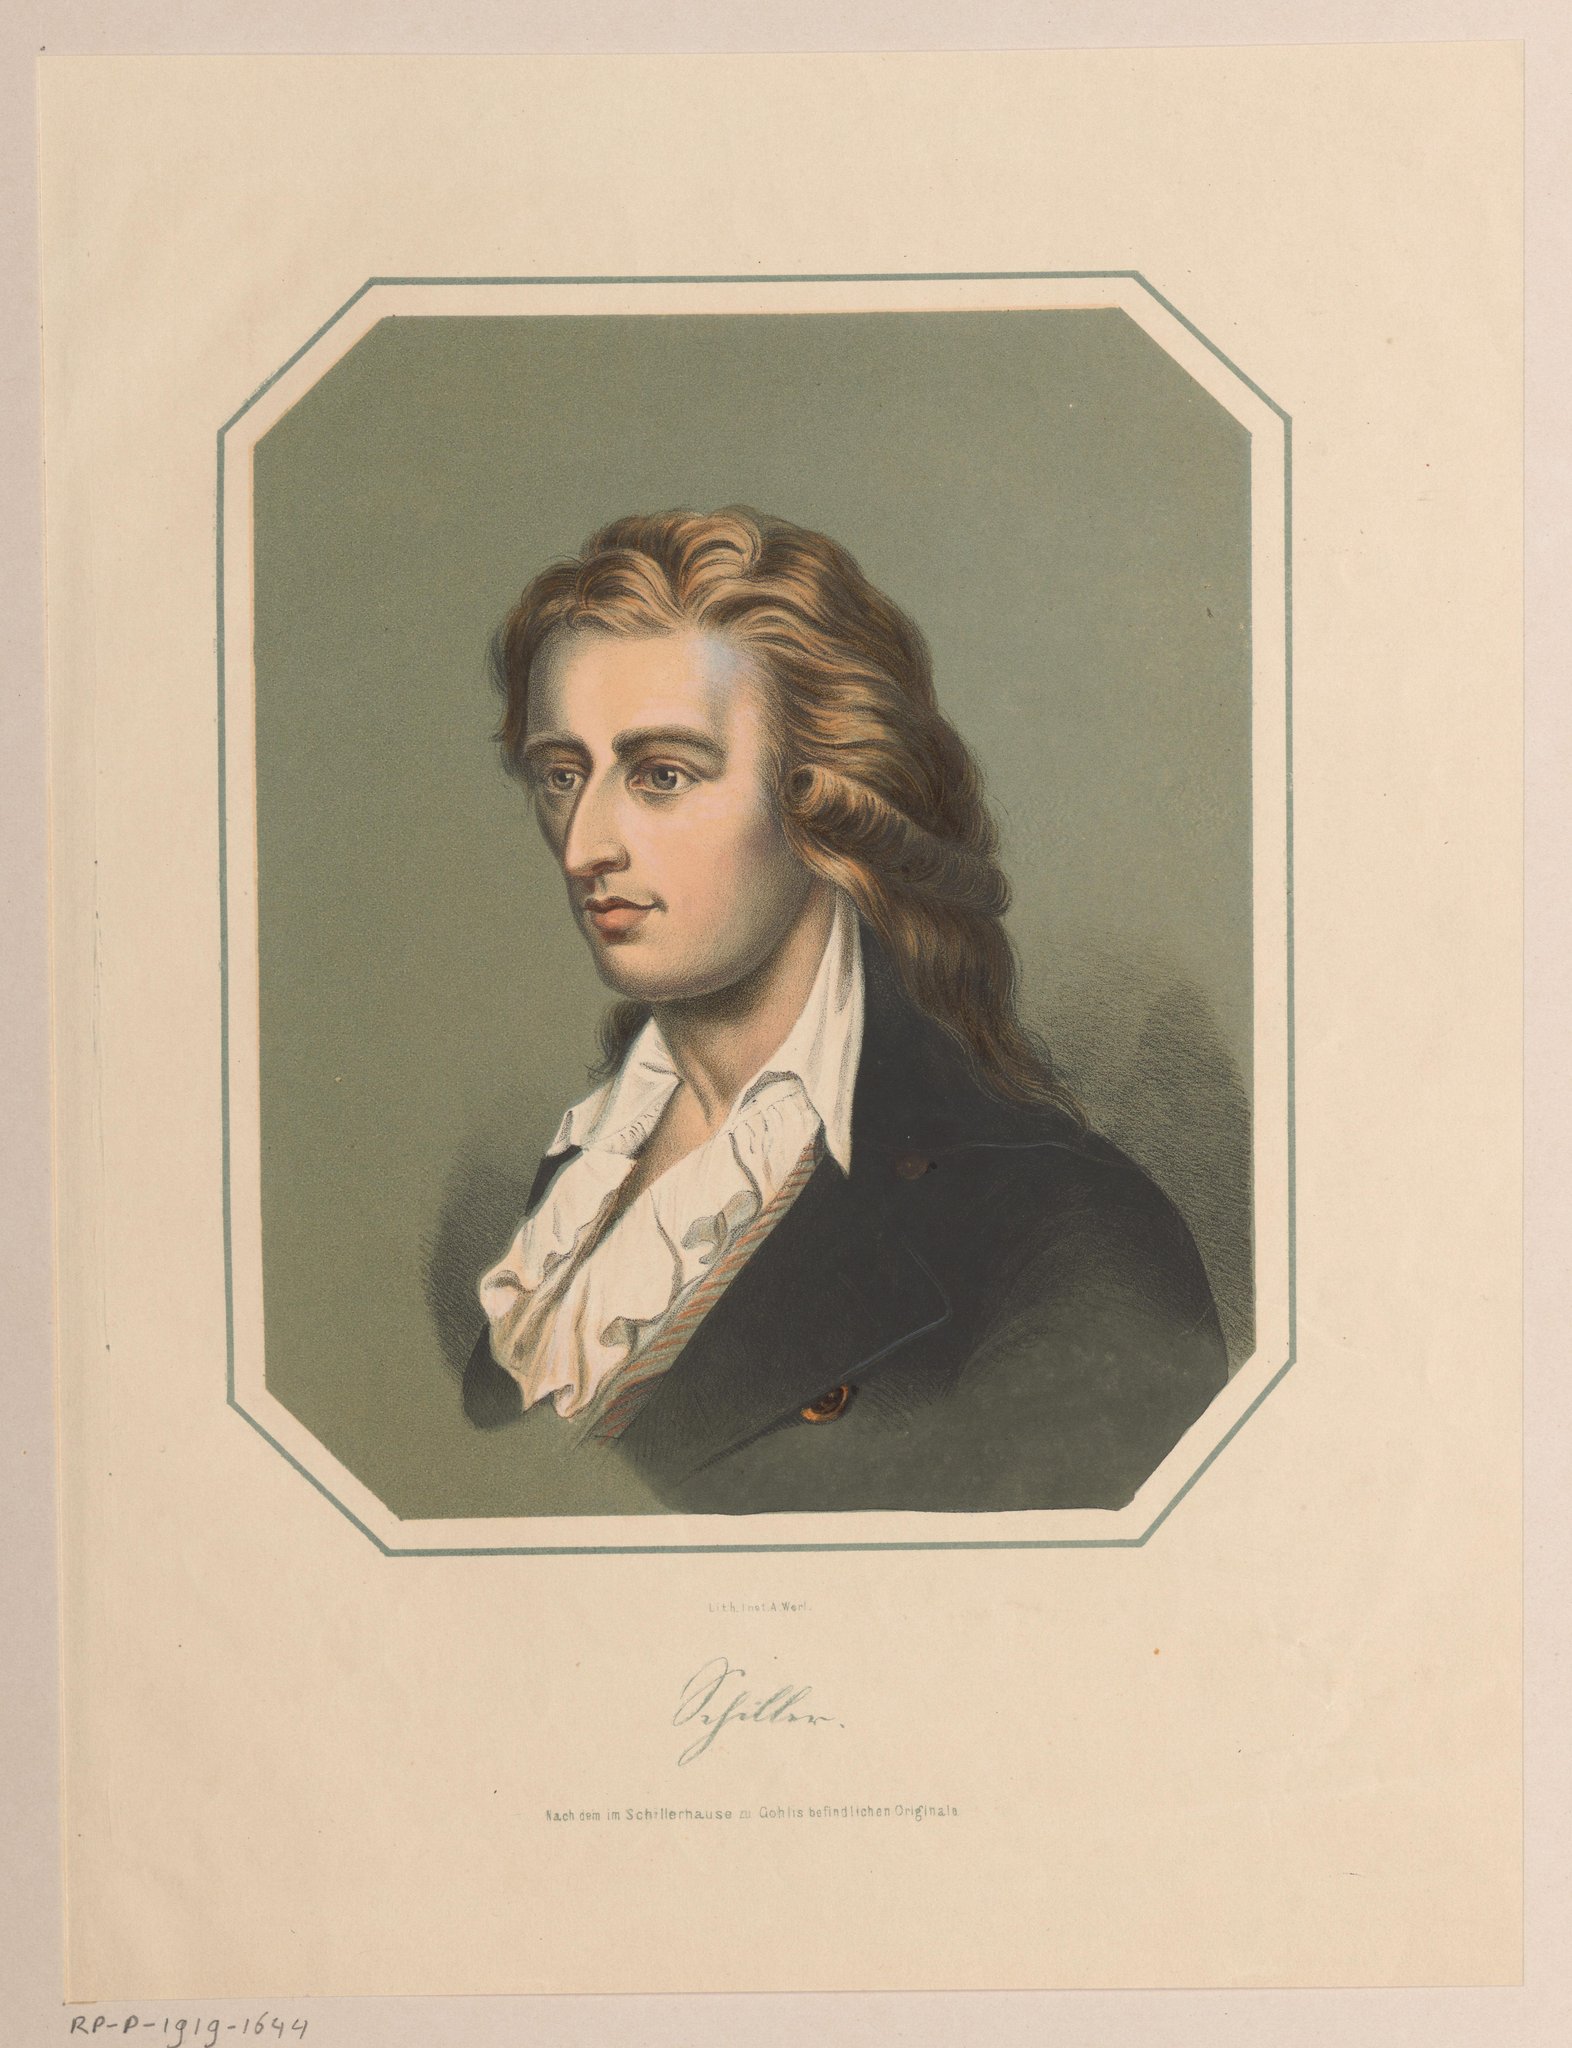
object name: print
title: Portret van Friedrich von Schiller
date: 1853-1860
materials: paper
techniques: hand coloring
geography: gohlis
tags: friedrich von schiller, scholar, philosopher, historical persons, portrait of a writer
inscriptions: collector's mark: Lugt 2228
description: Deze prent is mogelijk verschenen bij een uitgave van het tijdschrift 'Faust'.